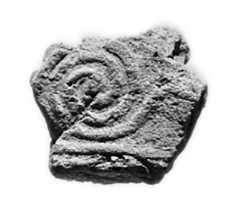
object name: sealing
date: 1981-1640 BCE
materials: mud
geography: egypt